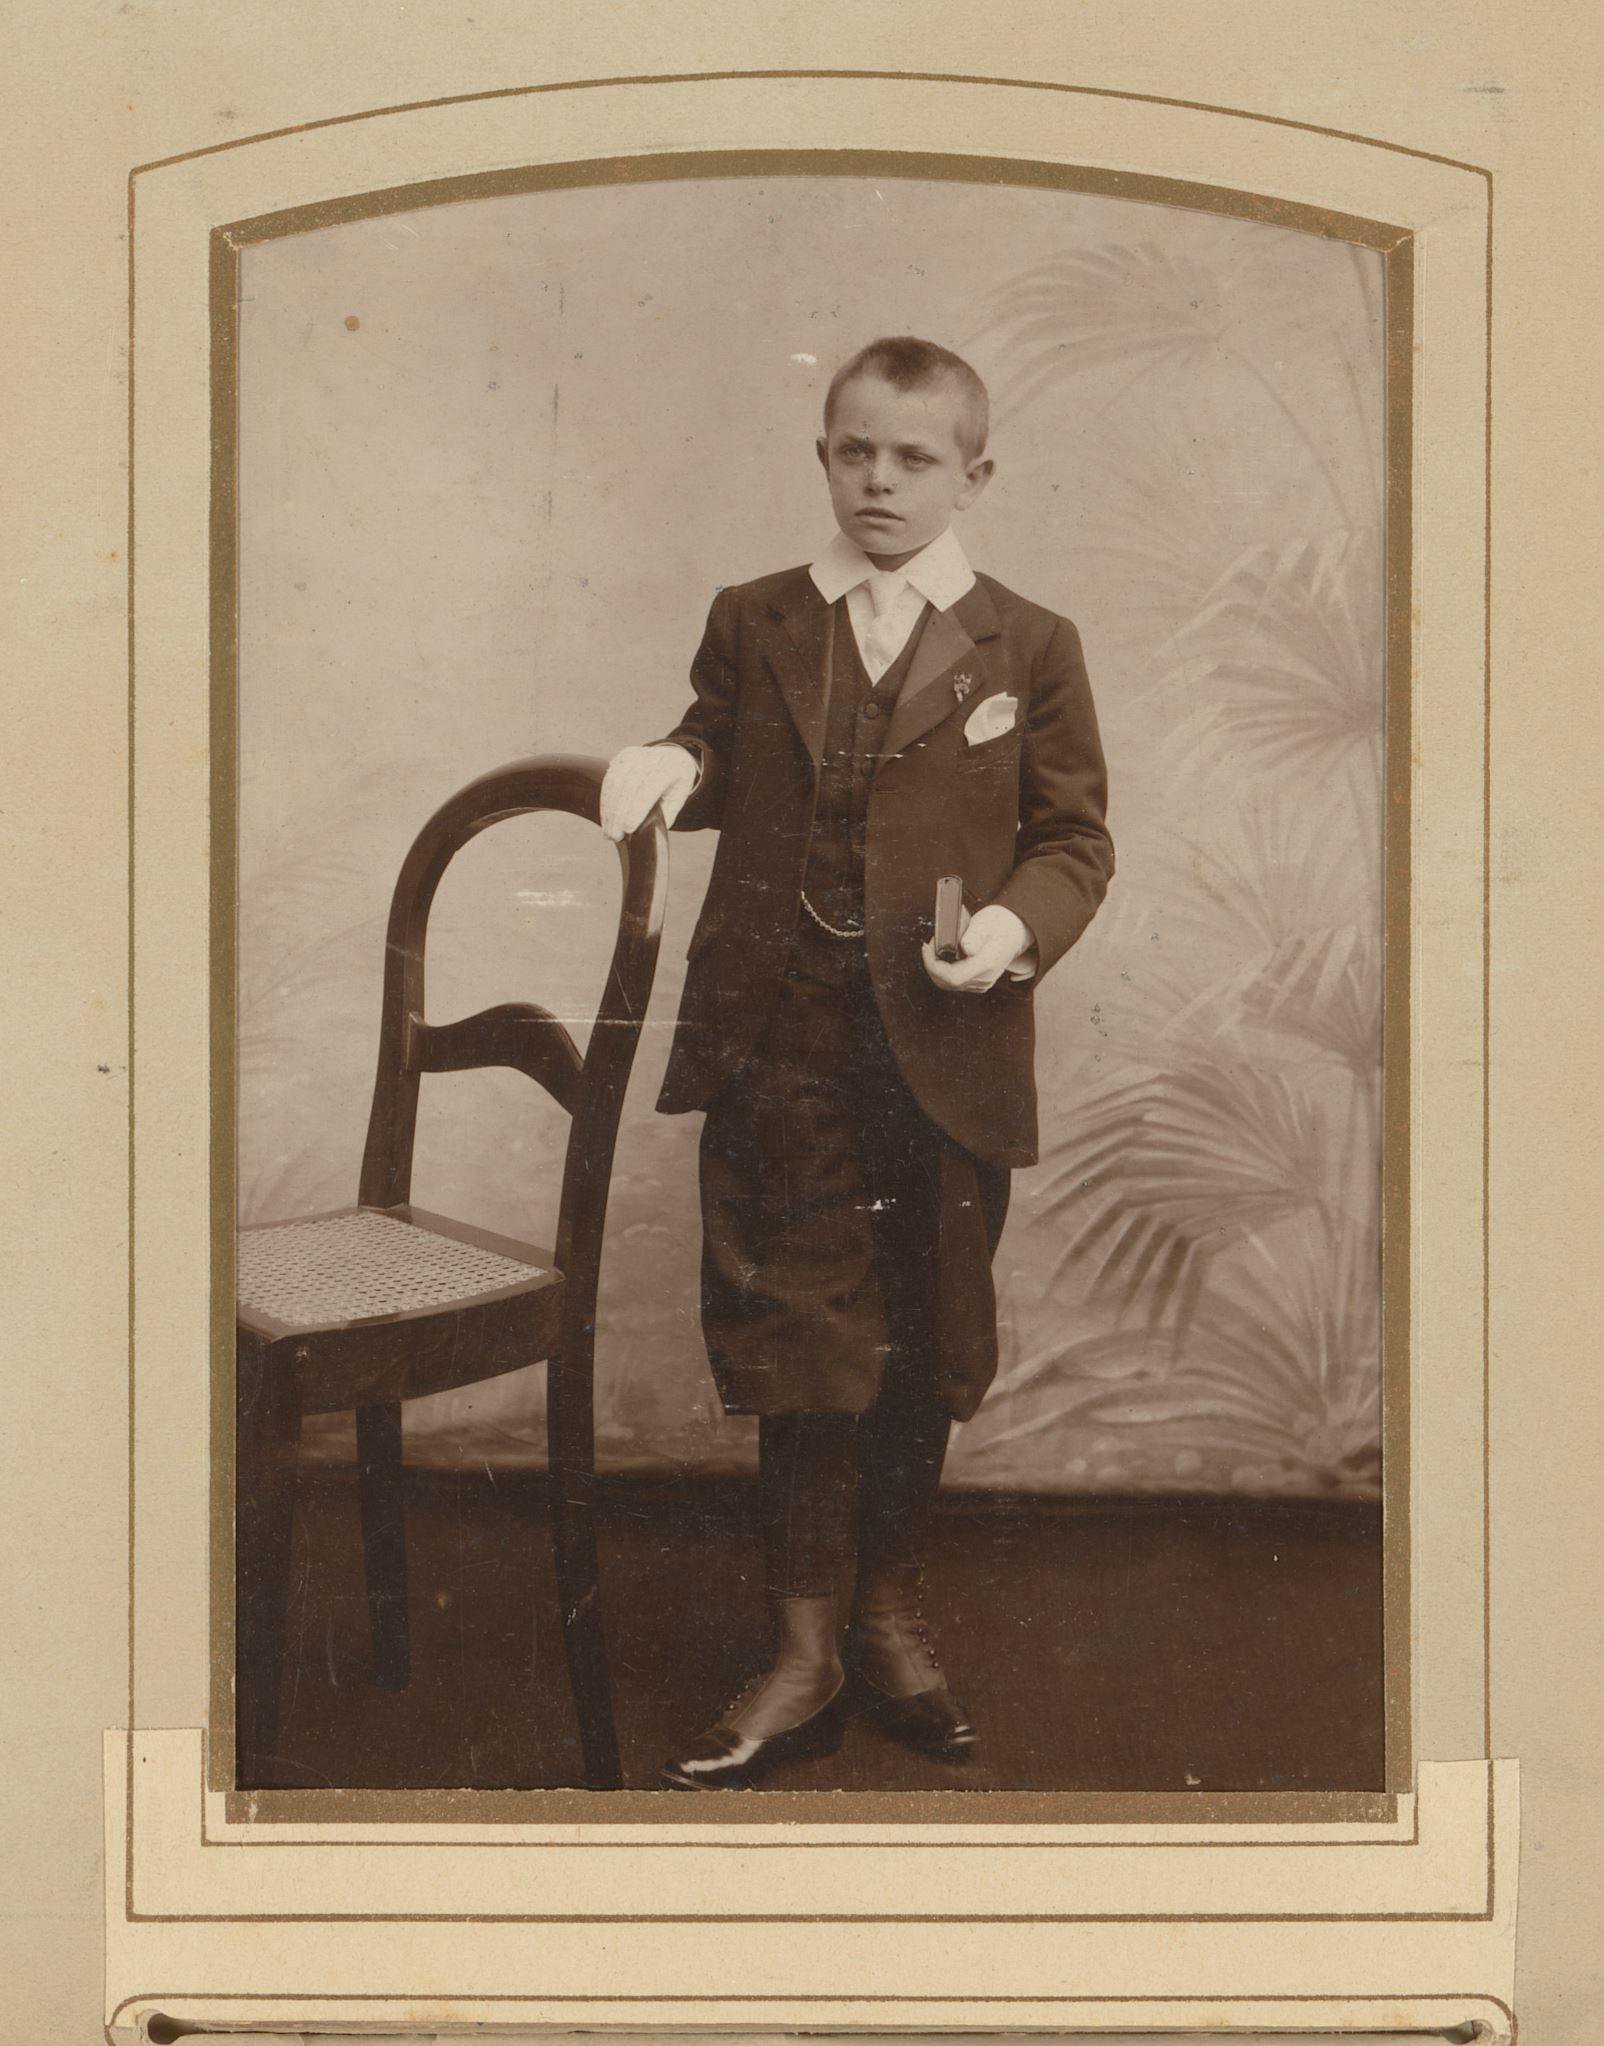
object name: album leaf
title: Portret van een jongen in communiepak, staand bij een stoel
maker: Anonymous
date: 1860-1900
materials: cardboard, photographic support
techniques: collodion silver print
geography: belgium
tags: first communion, boy (child between toddler and youth), historical persons